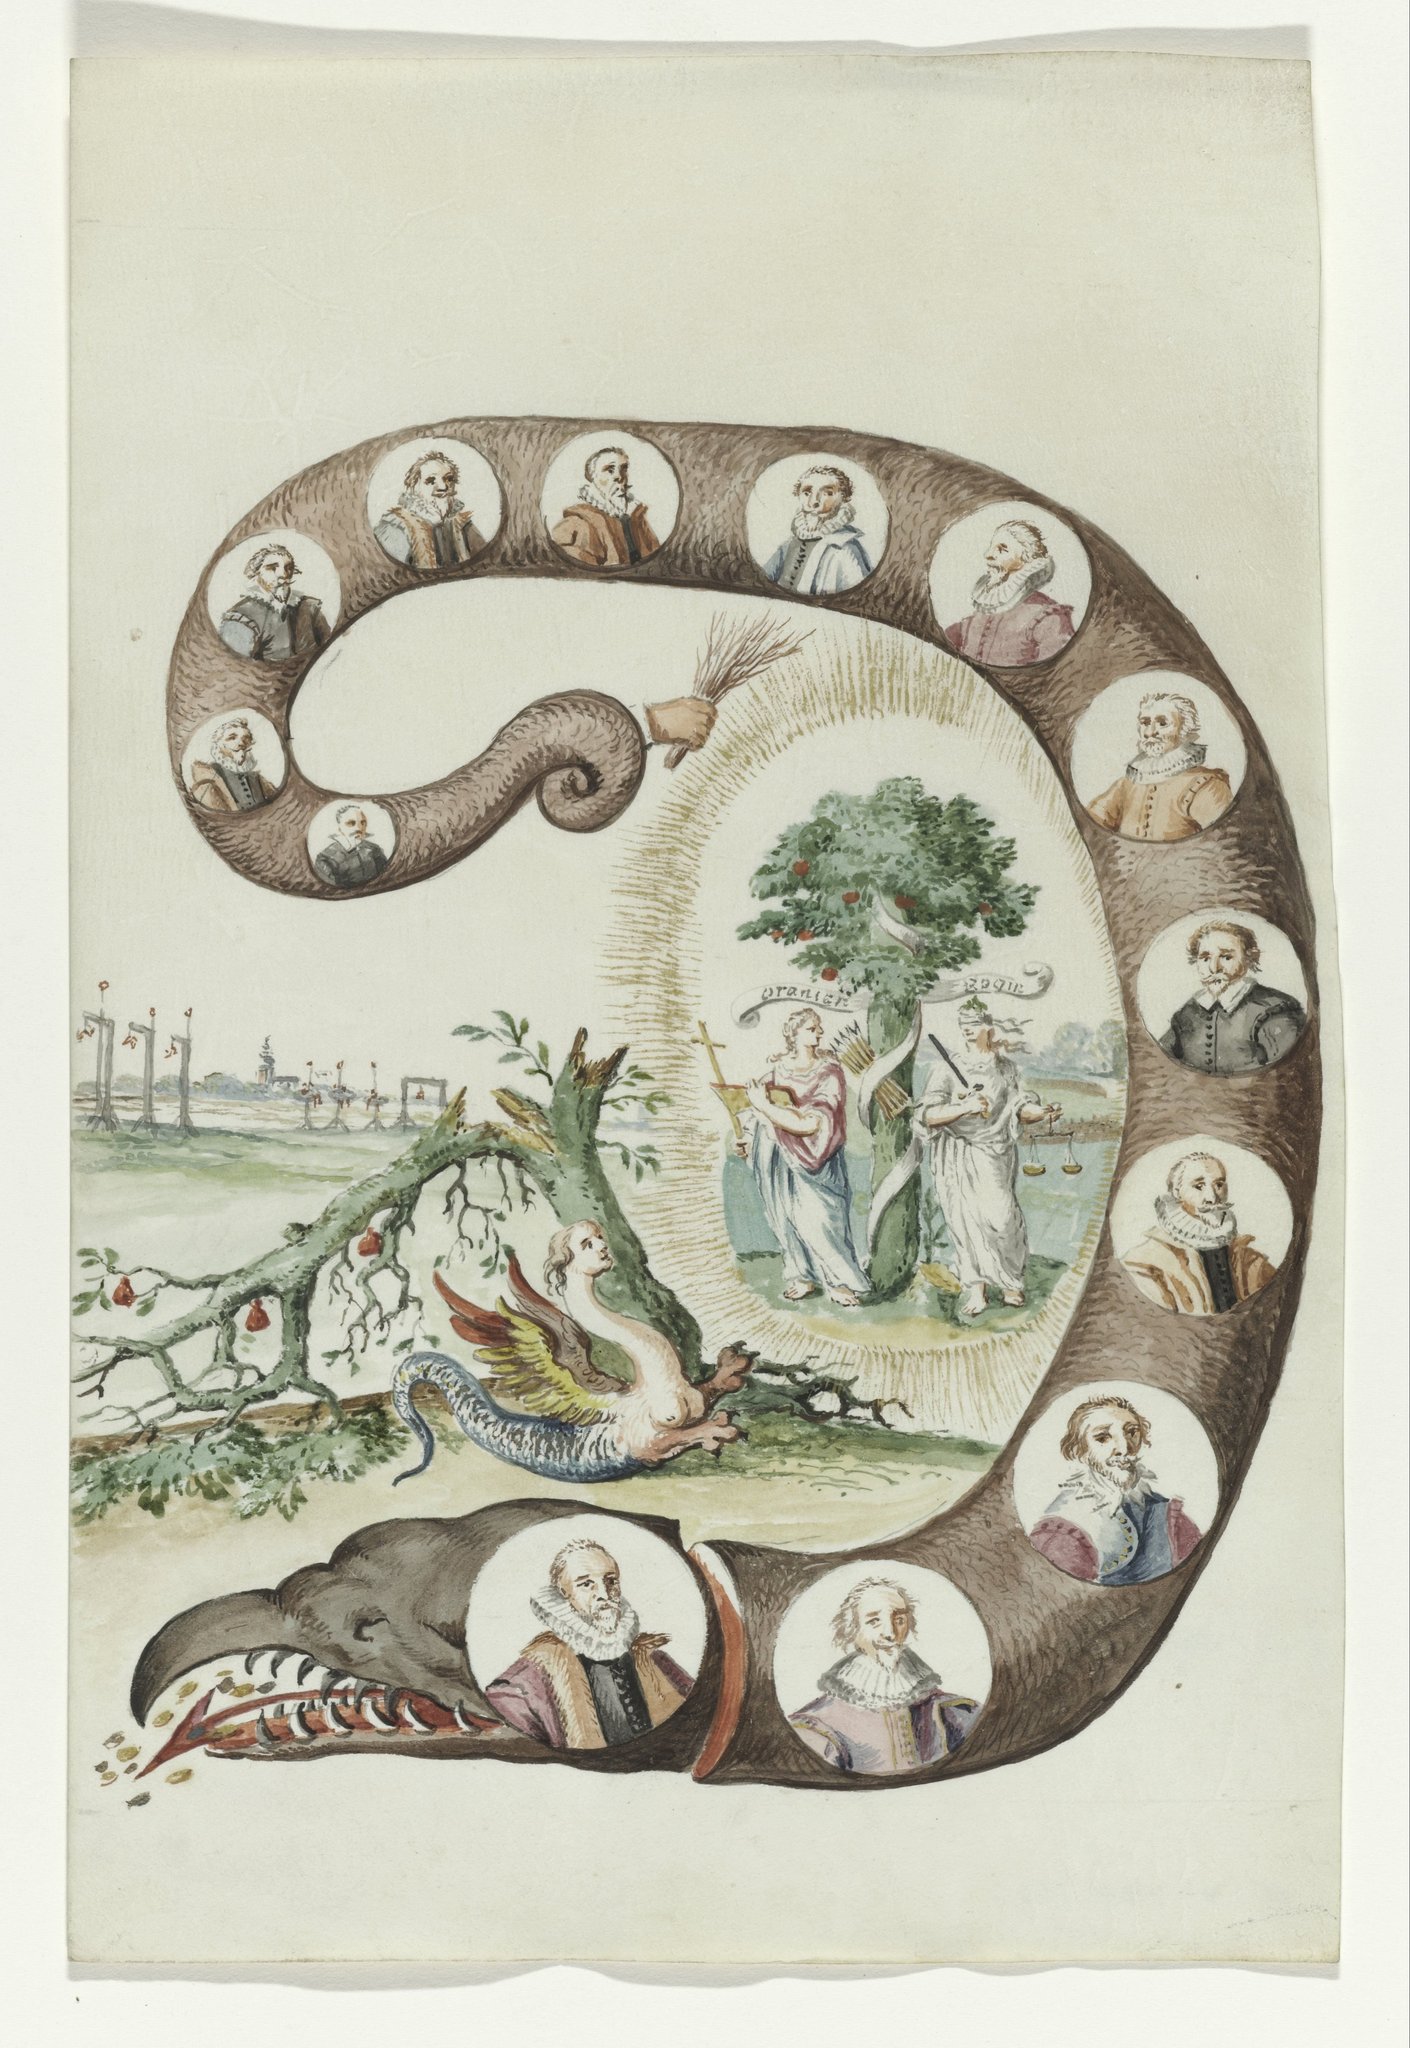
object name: drawing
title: Regtspleging van Oldenbarnevelt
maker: Anonymous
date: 1710-1720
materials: ink, parchment, watercolor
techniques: brush, pen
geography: netherlands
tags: the hague, johan van oldenbarnevelt, instruments of torture, execution or punishment: gallows, justice, 'justitia'; 'giustitia divina' (ripa) ~ one of the four cardinal virtues, dragon (large fabulous serpent, sometimes with wings and legs), faith, 'fides'; 'fede', 'fede catholica', 'fede christiana', 'fede christiana catholica' (ripa) ~ one of the three theological virtues, fabulous animals ~ snakes (aspic, dragon, hydrus, hydra, amphisbaena, horned snake, cerastes), political caricatures and satires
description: Slang met afgehouwen kop waarop het portret van Oldenbarnevelt. Op het lichaam van de slang 13 cirkels met daarin portretten van de samenzweerders tegen prins Maurits, gearresteerd en veroordeeld in 1623. Het uiteinde van de slang heeft de vorm van een hand met een roede. Links een draak bij de gebroken Arminiaanse boom. Rechts de stralende Oranjeboom met de deugden Geloof en Gerechtigheid. Op de achtergrond links een galgenveld. Met handgeschreven toelichting. Behorende bij serie aquarellen in boek.